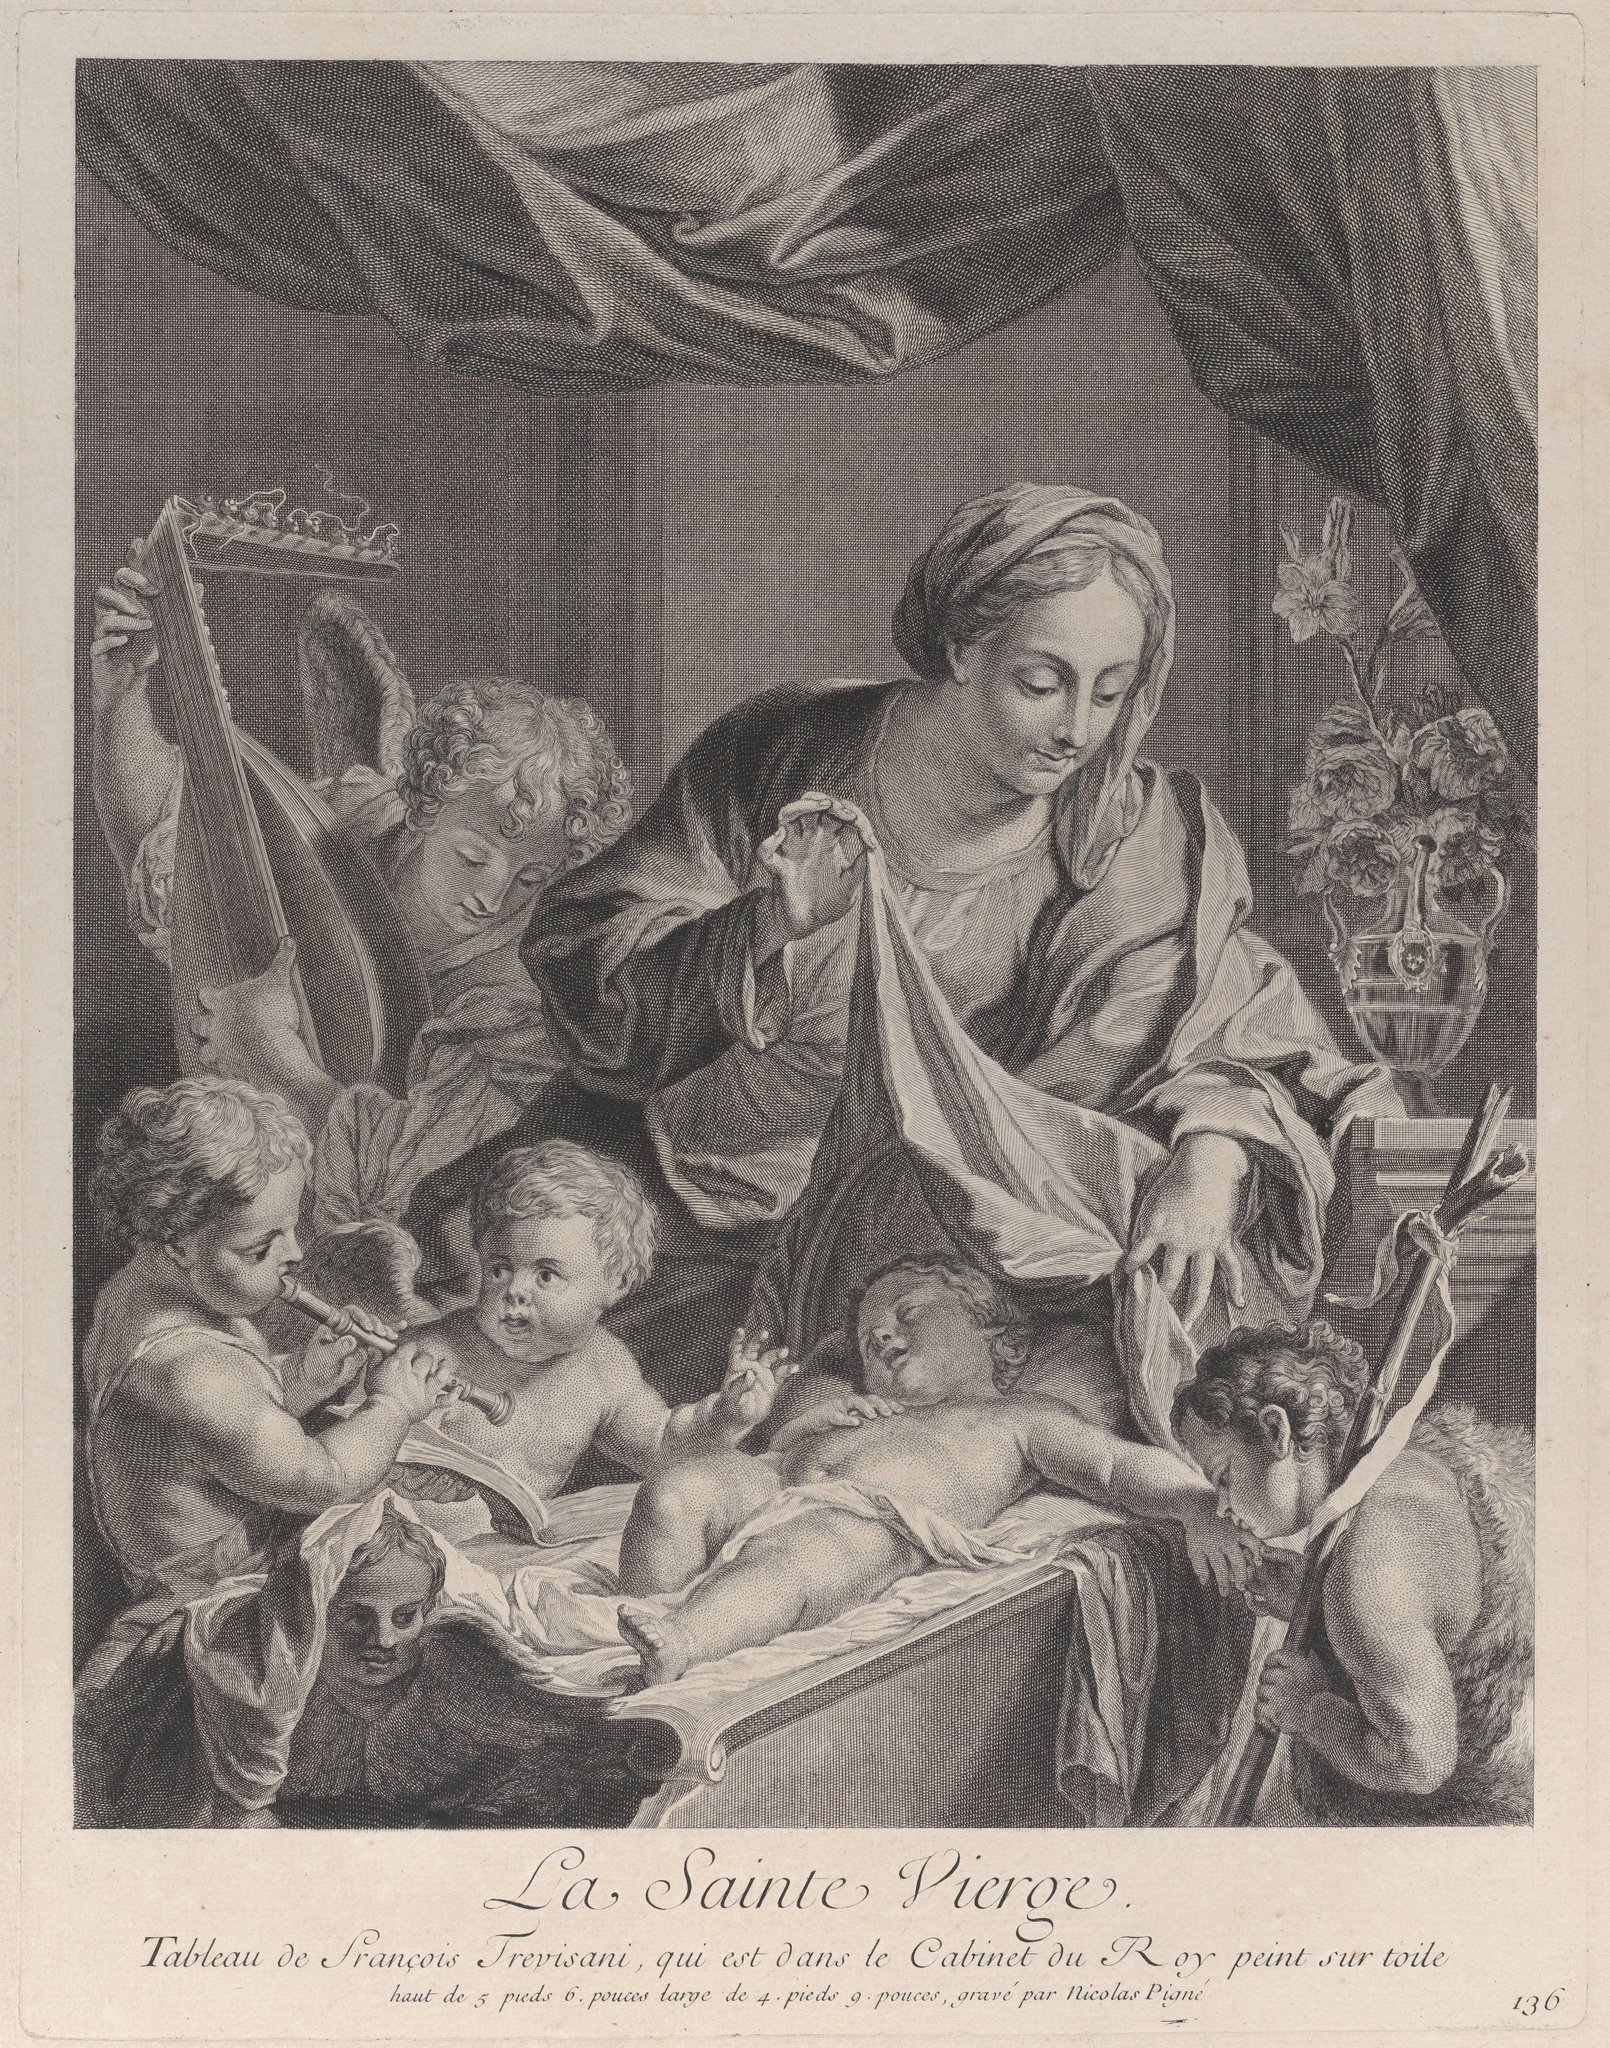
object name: print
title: The Virgin holding a cloth above the sleeping Christ child, with musical angels and the infant Saint John the Baptist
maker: nicolas pigné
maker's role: artist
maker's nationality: french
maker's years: 1700-1800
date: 1729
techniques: etching